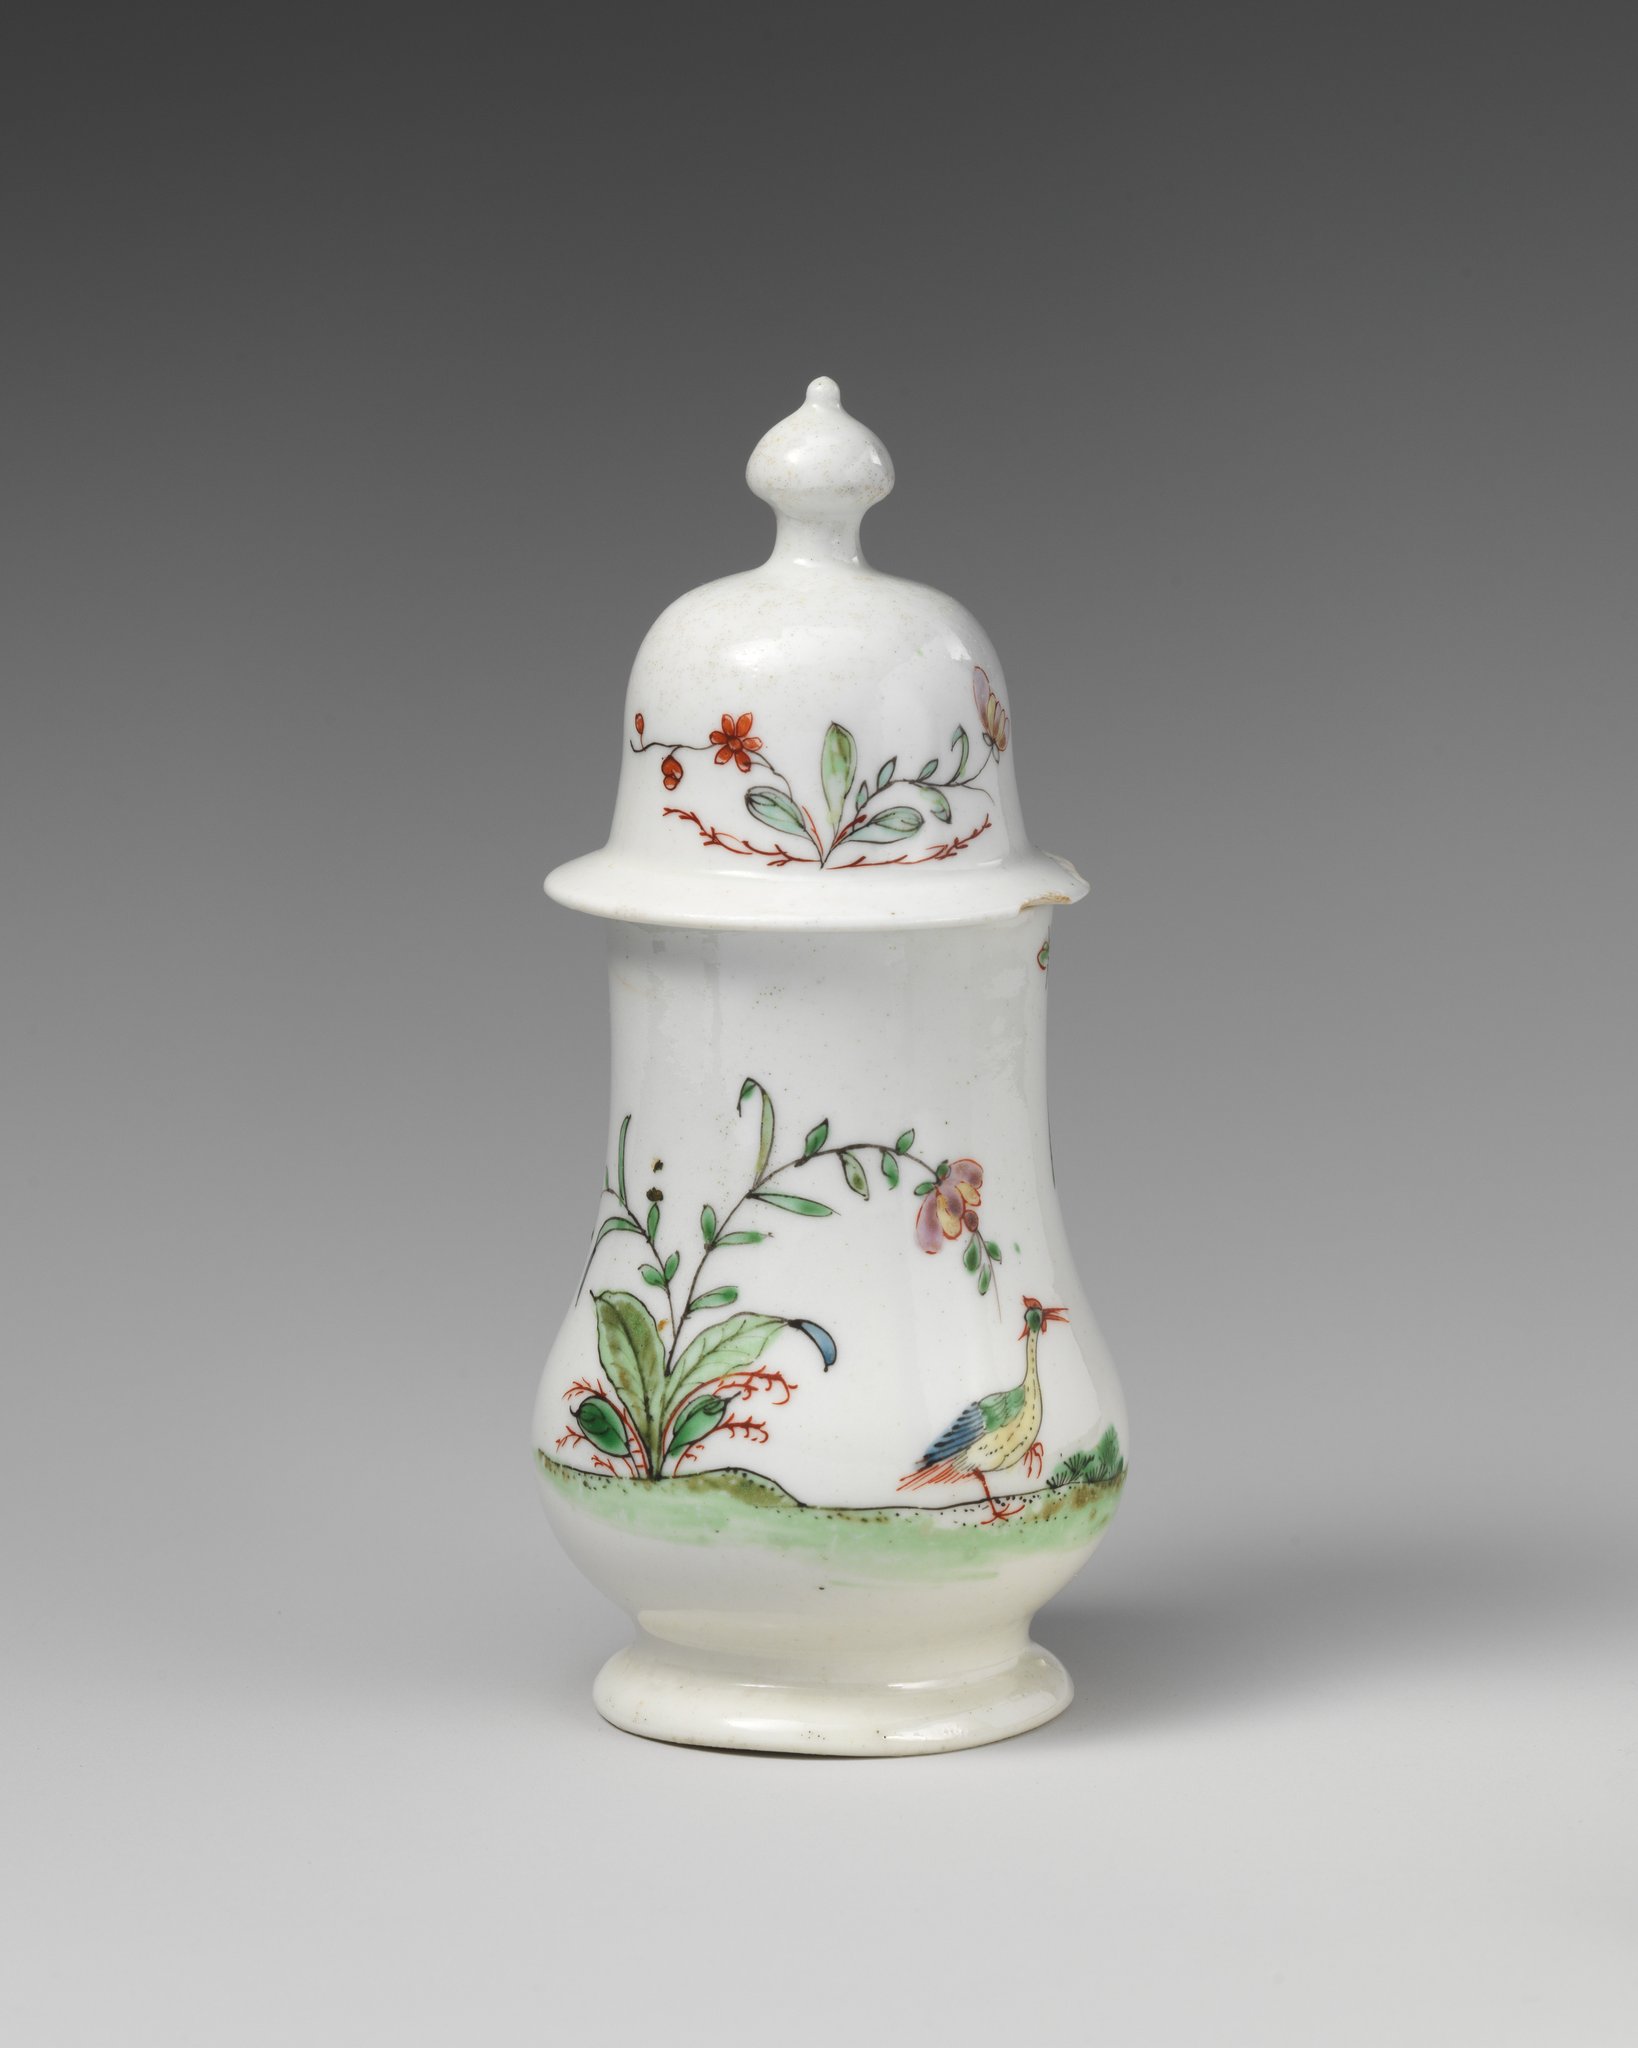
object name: mustard pot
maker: worcester factory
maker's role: factory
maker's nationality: british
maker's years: 1751-2008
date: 1701-1800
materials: soft paste porcelain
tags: birds,flowers,plants